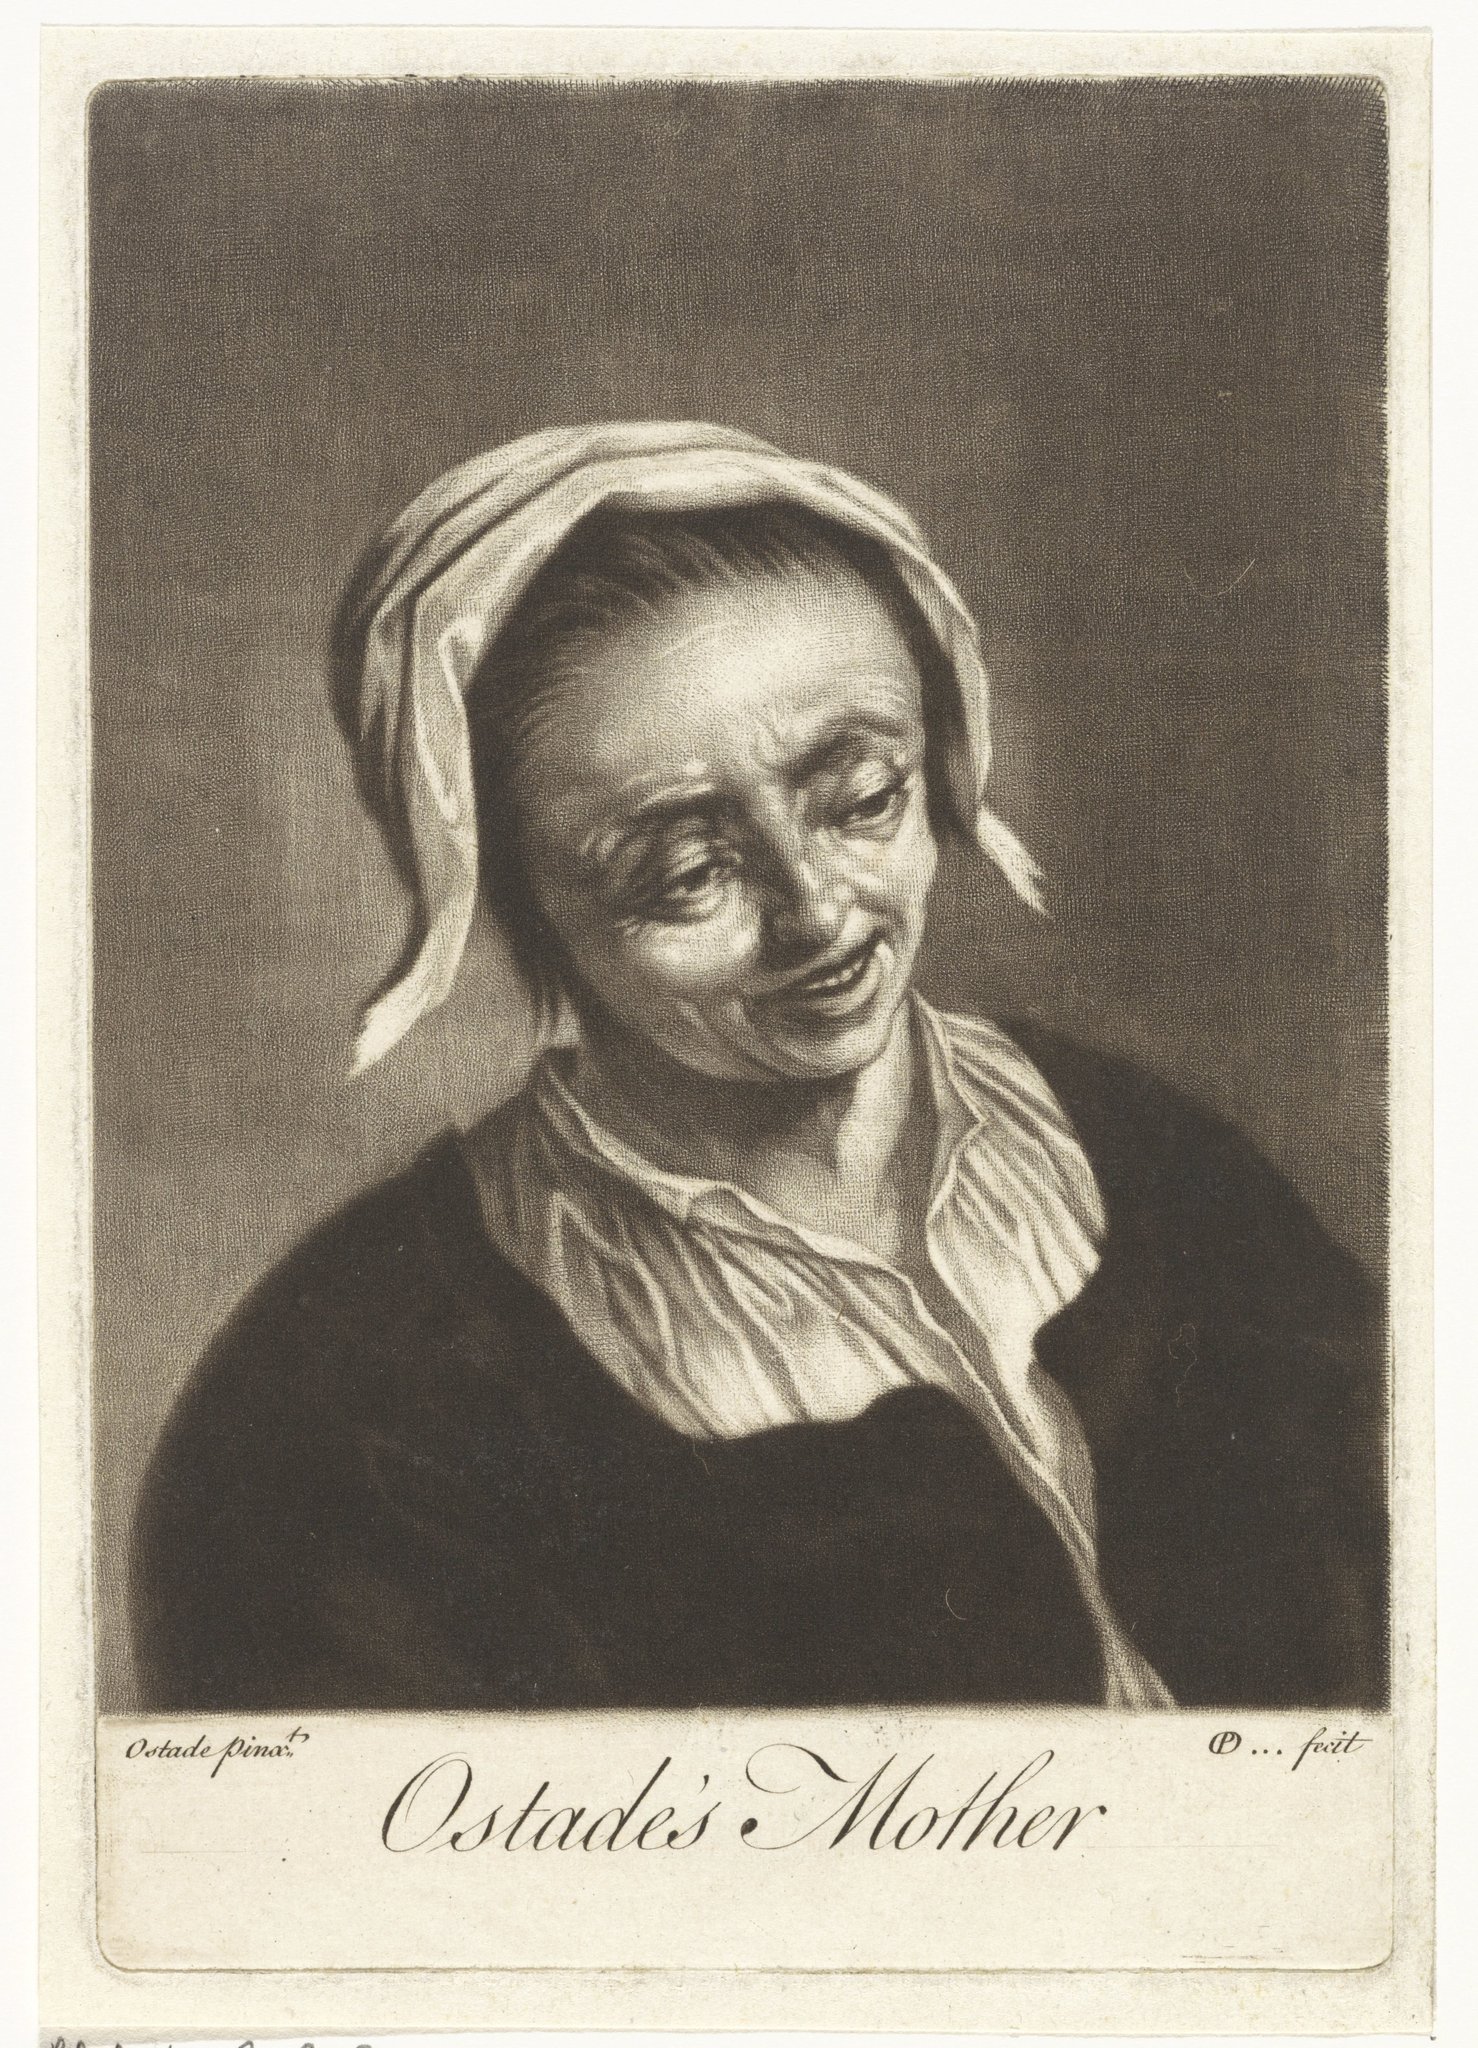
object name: print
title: Portret van de moeder van Adriaen en Isaac van Ostade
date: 1730-1790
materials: paper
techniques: engraving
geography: amsterdam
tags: mother and baby or young child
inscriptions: collector's mark: Lugt 2228